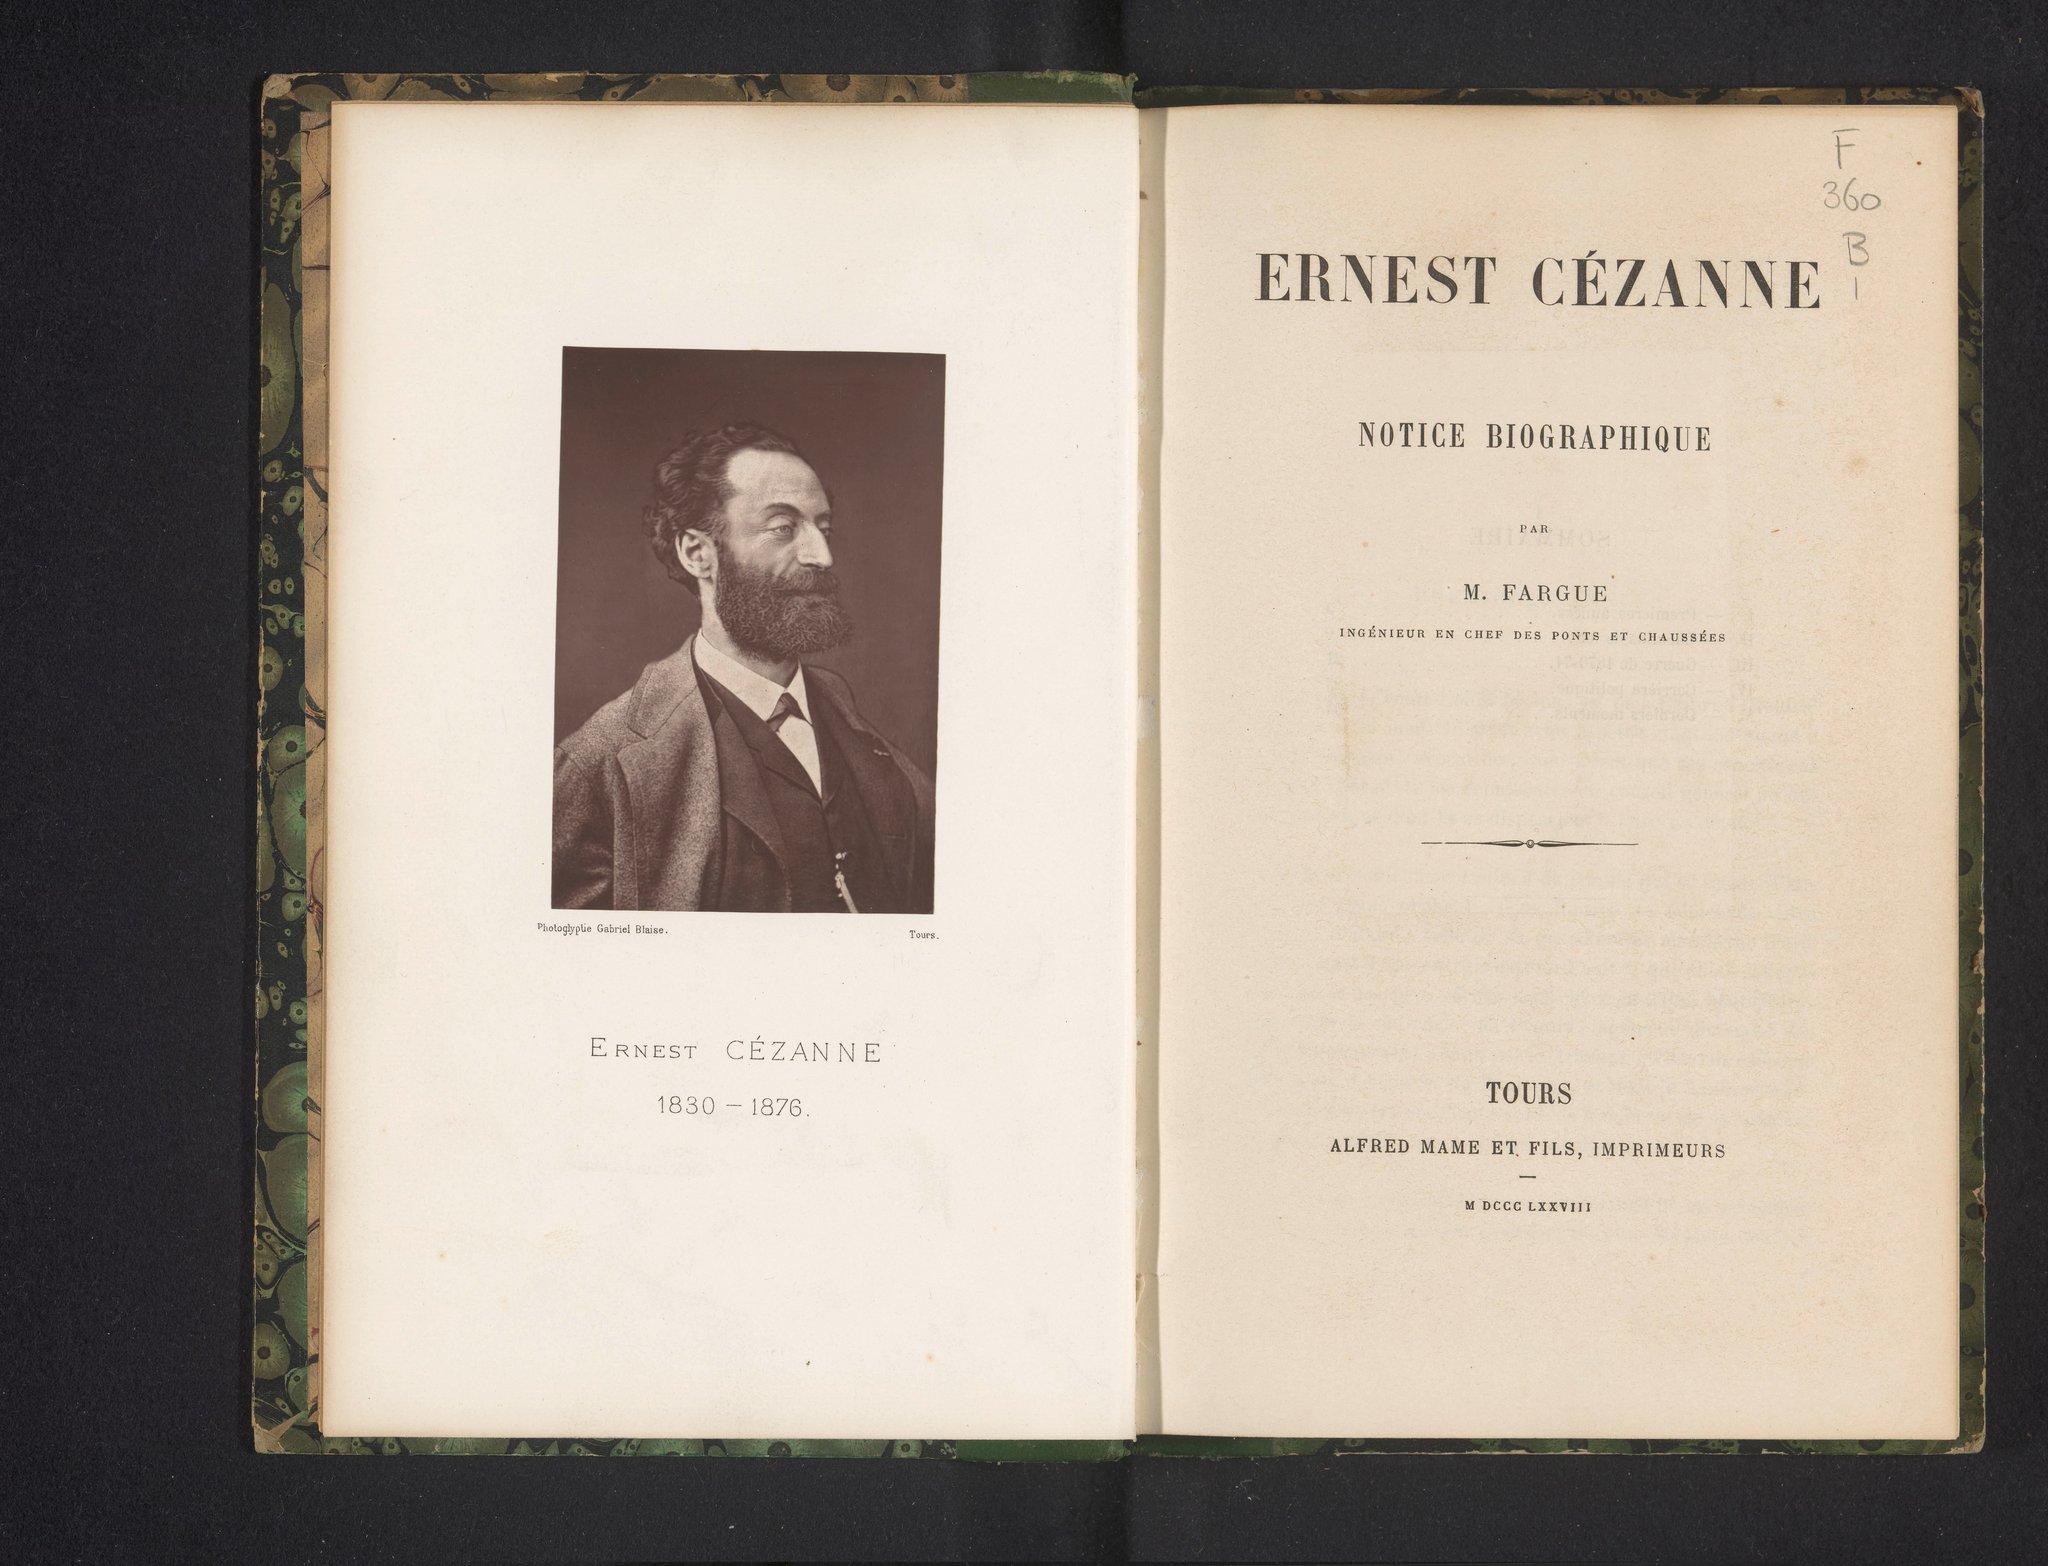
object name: book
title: Ernest Cézanne : notice biographique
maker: m. fargue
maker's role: engineer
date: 1878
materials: linen, paper, photographic support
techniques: printing, marbled paper, woodburytype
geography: tours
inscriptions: annotation: ‘ex-W. [...]/ 1993’